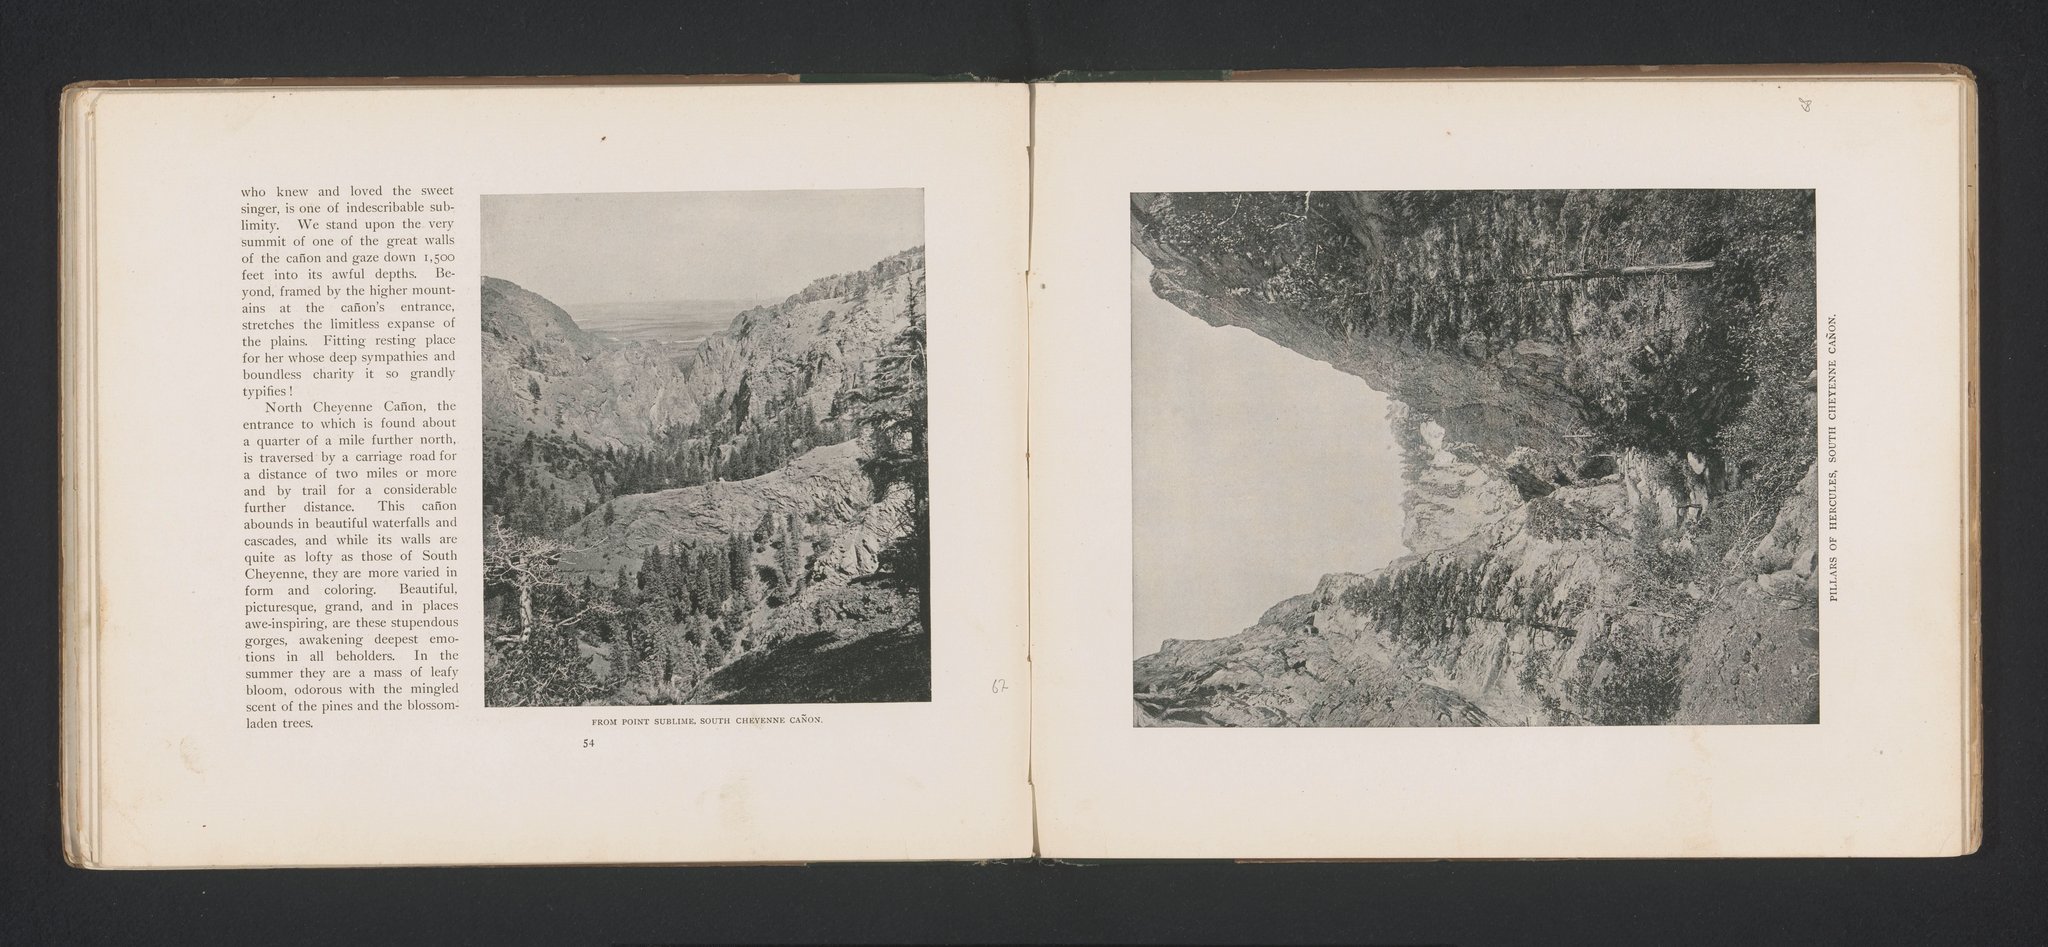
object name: page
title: From point sublime, South Cheyenne Cañon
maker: Anonymous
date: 1888-1893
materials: paper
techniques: autotype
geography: new york city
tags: landscapes, ravine, chasm, abyss, canyon